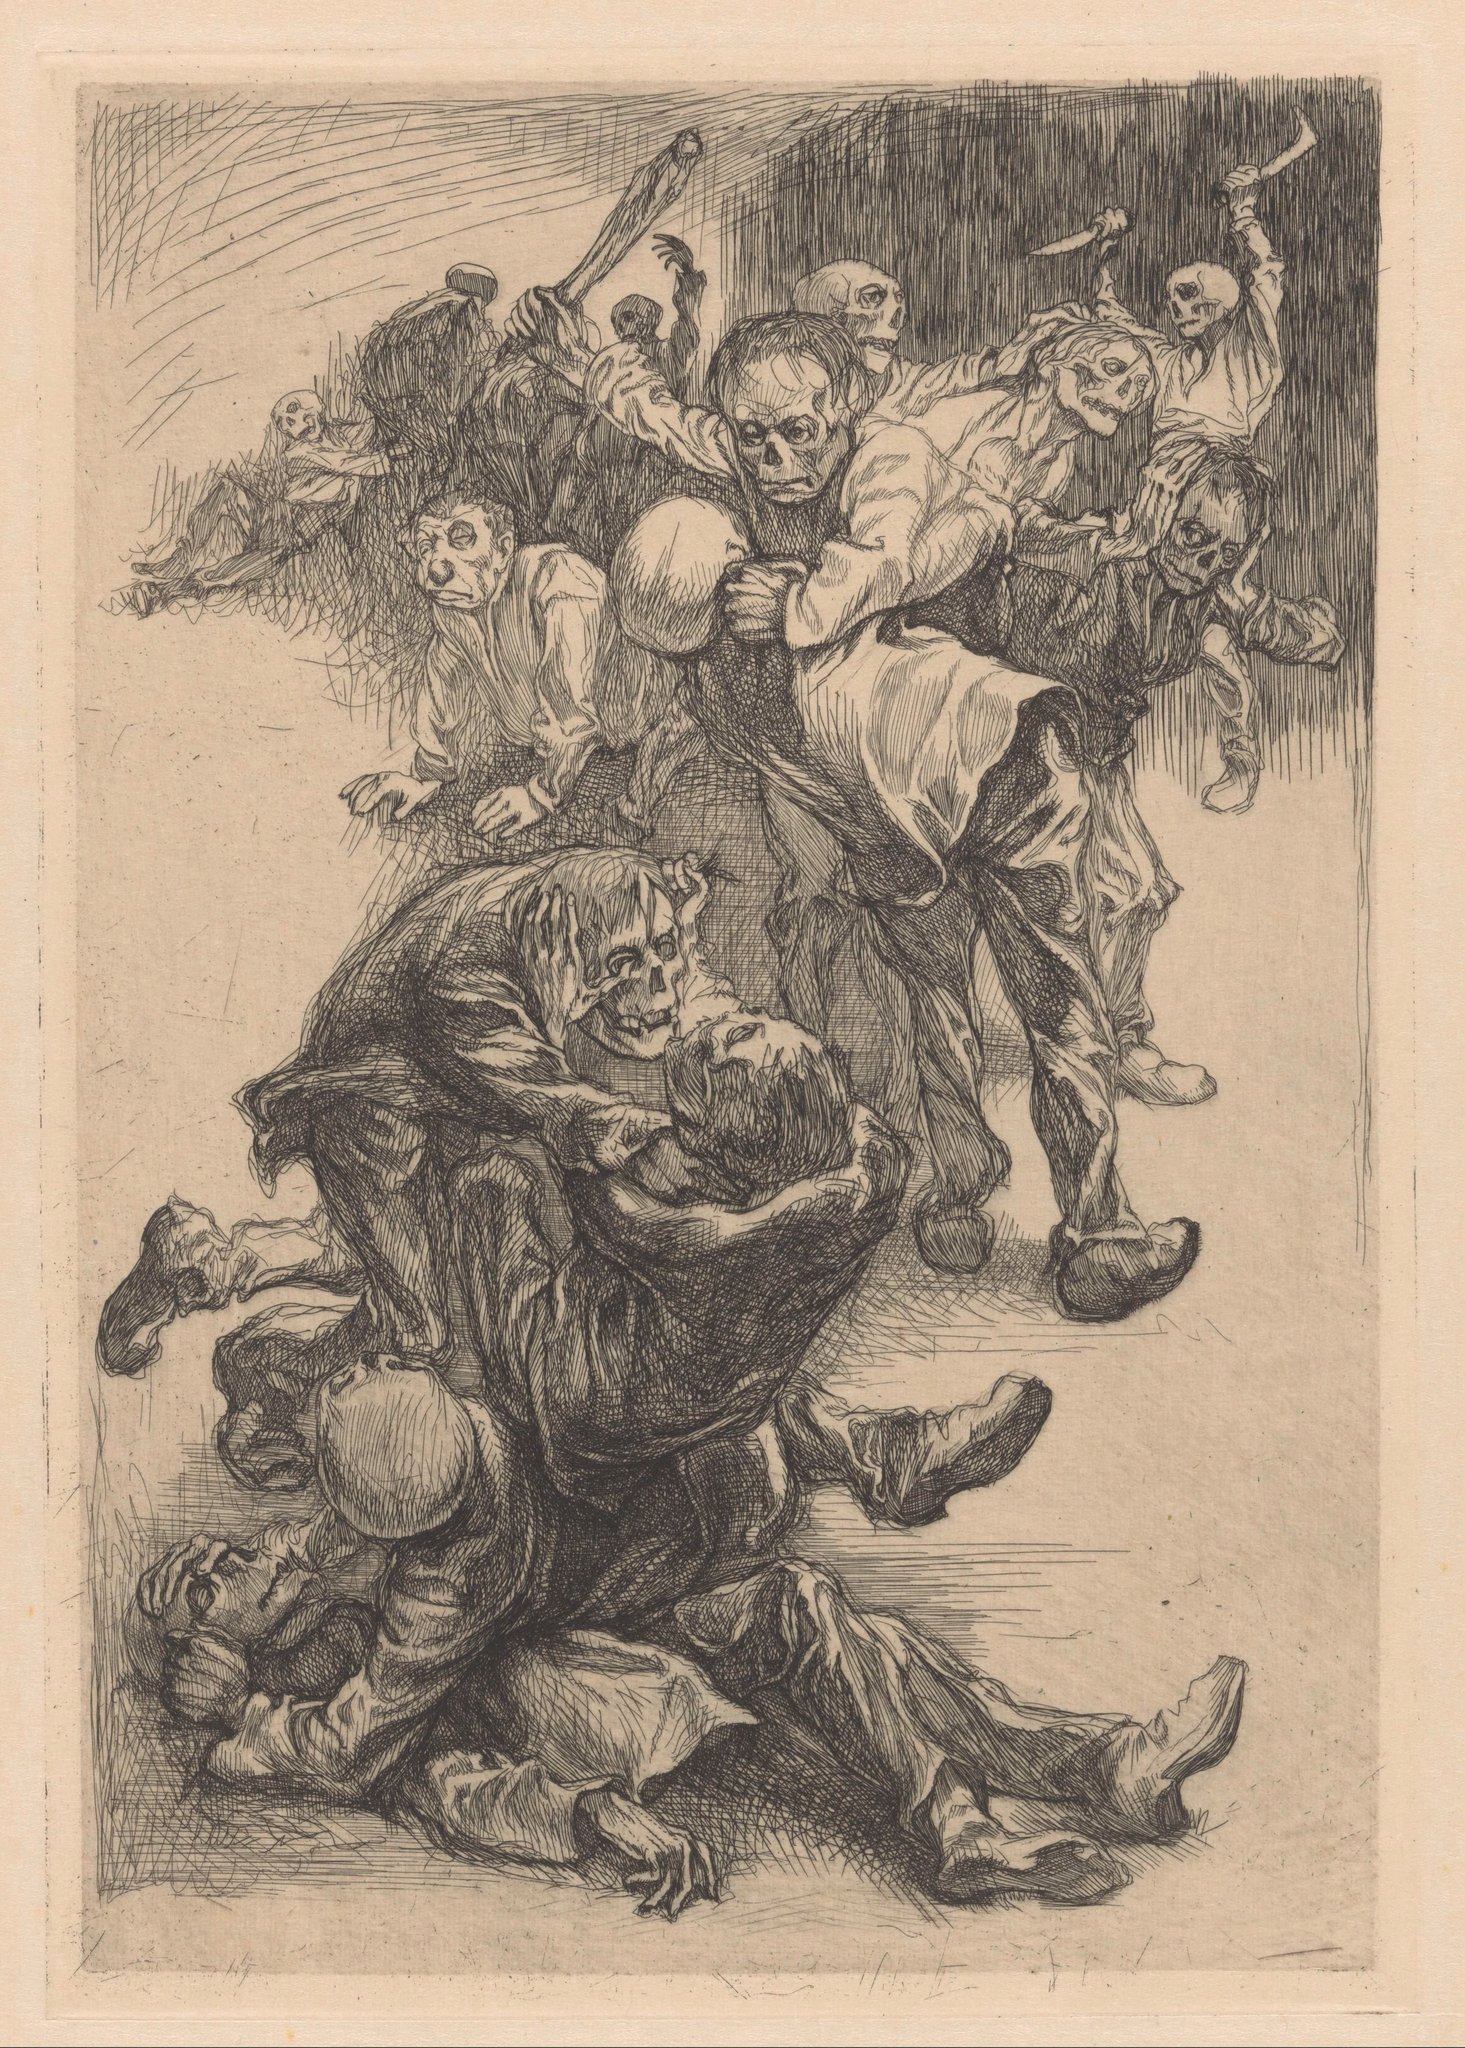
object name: print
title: Vechtende monsters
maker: johannes josephus aarts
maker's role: draughtsman, print maker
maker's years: 1871-1934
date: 1881-1934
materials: paper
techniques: etching, intaglio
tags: weapons, mis-shapen animals; monsters, fighting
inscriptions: collector's mark: Lugt 2228, collector's mark: Lugt 2760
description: Een groep monsters gaat elkaar te lijf. Twee van hen zijn in het bezit van een wapen. Ze gebruiken een knuppel, dolk en zeis.